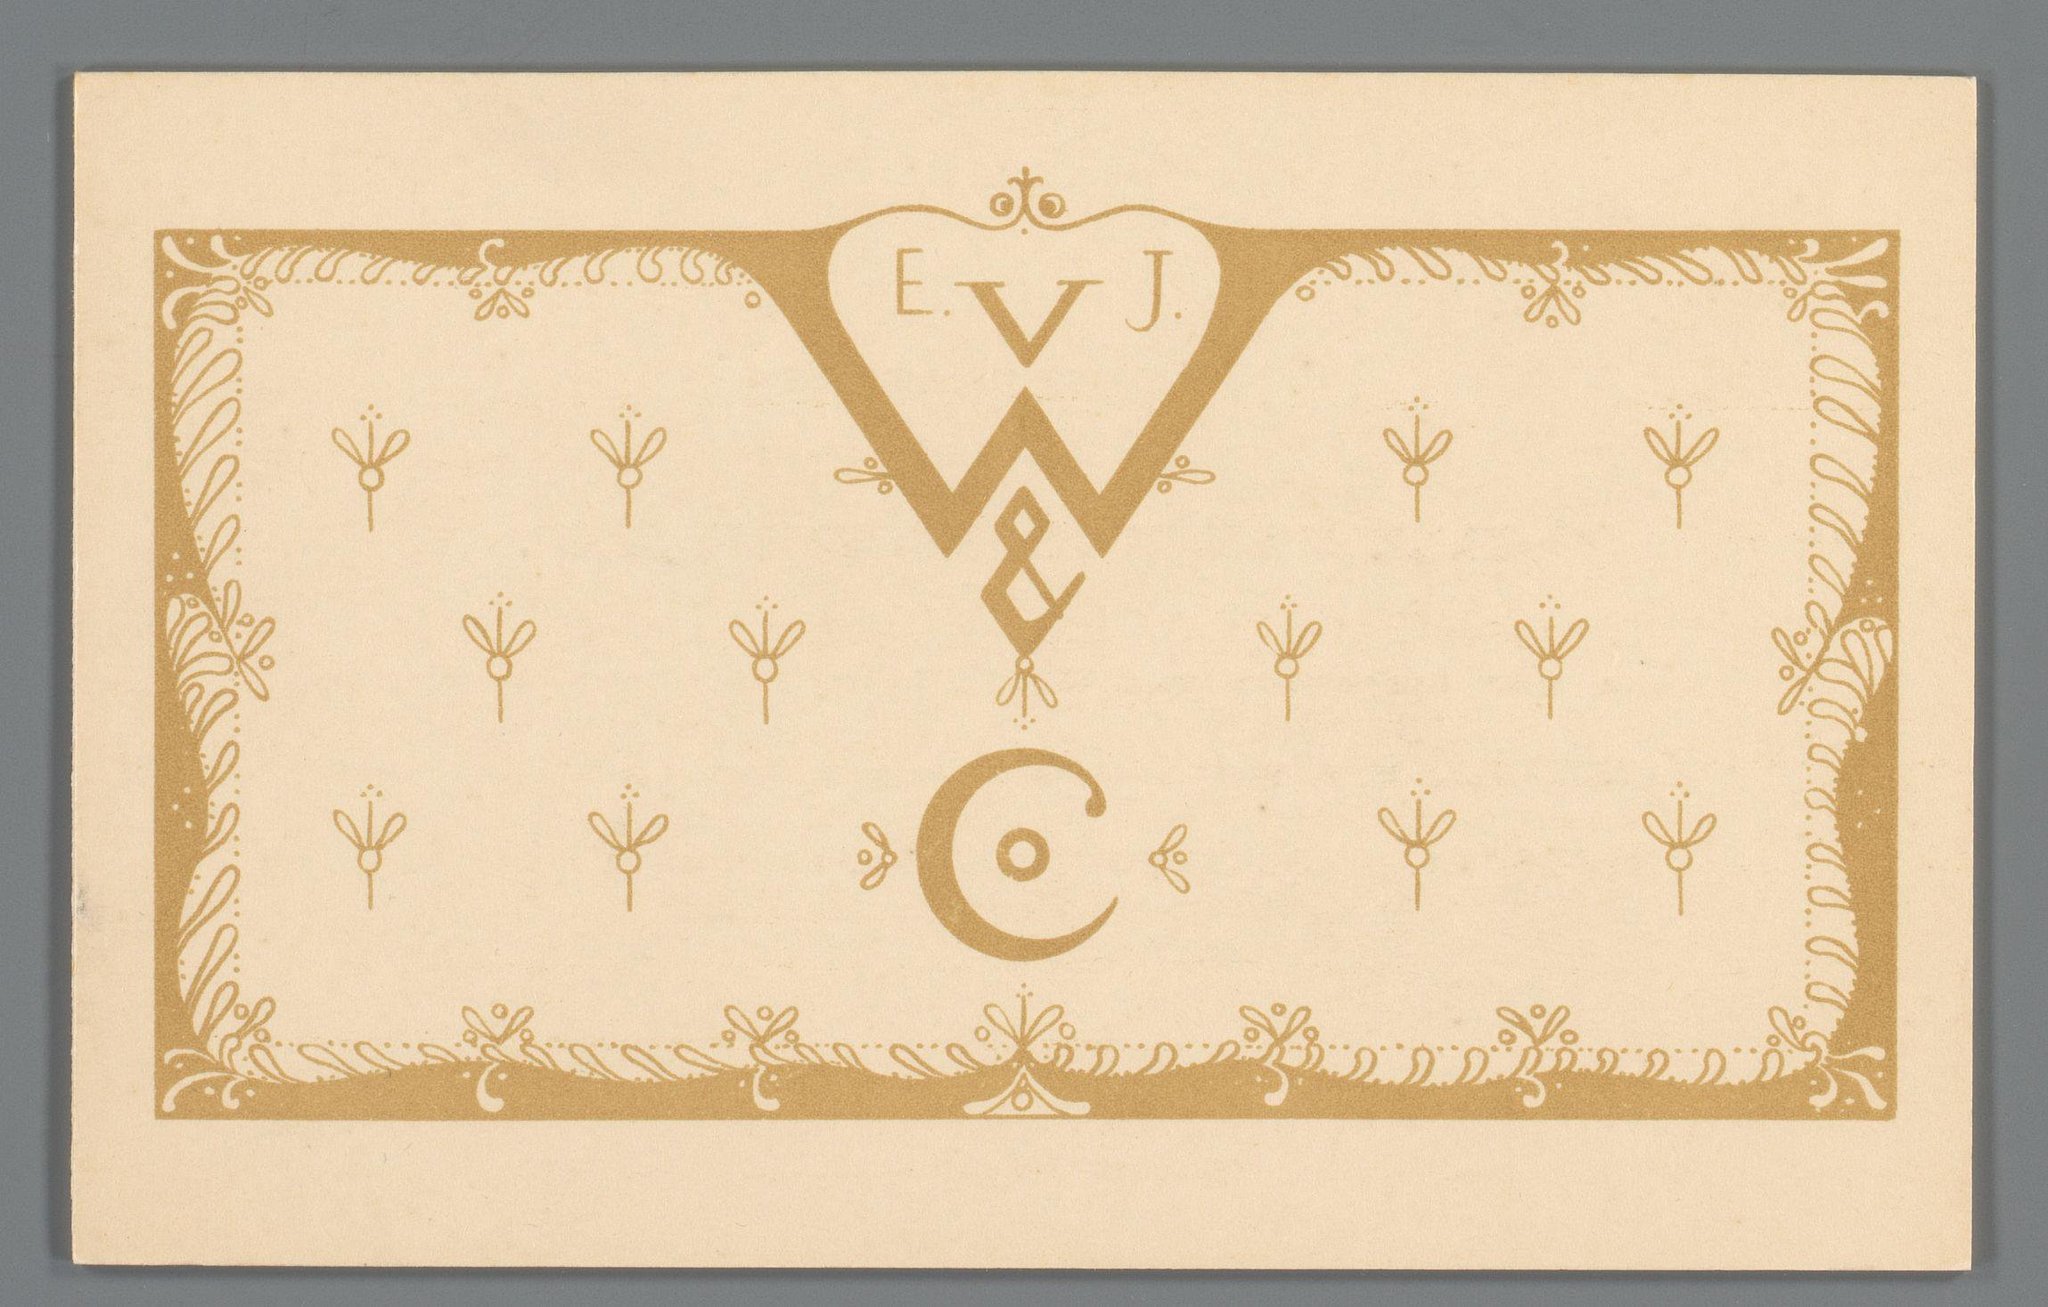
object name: print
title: Adreskaart van kunsthandel E.J. van Wisselingh & Co.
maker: Anonymous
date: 1907-1915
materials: paper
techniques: letterpress printing, lithograph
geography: amsterdam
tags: abstract, non-representational art, ornaments ~ art, amsterdam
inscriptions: date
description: Op de voor- en achterzijde een herhaalde voorstelling van bloemen in een veld met ornamenteel kader. In het midden daarvan het monogram van de firma 'E.J. v W & Co.'. Binnenin een tekst die aangeeft dat de werkplaatsen zullen verhuizen naar de Prinsengracht 824.